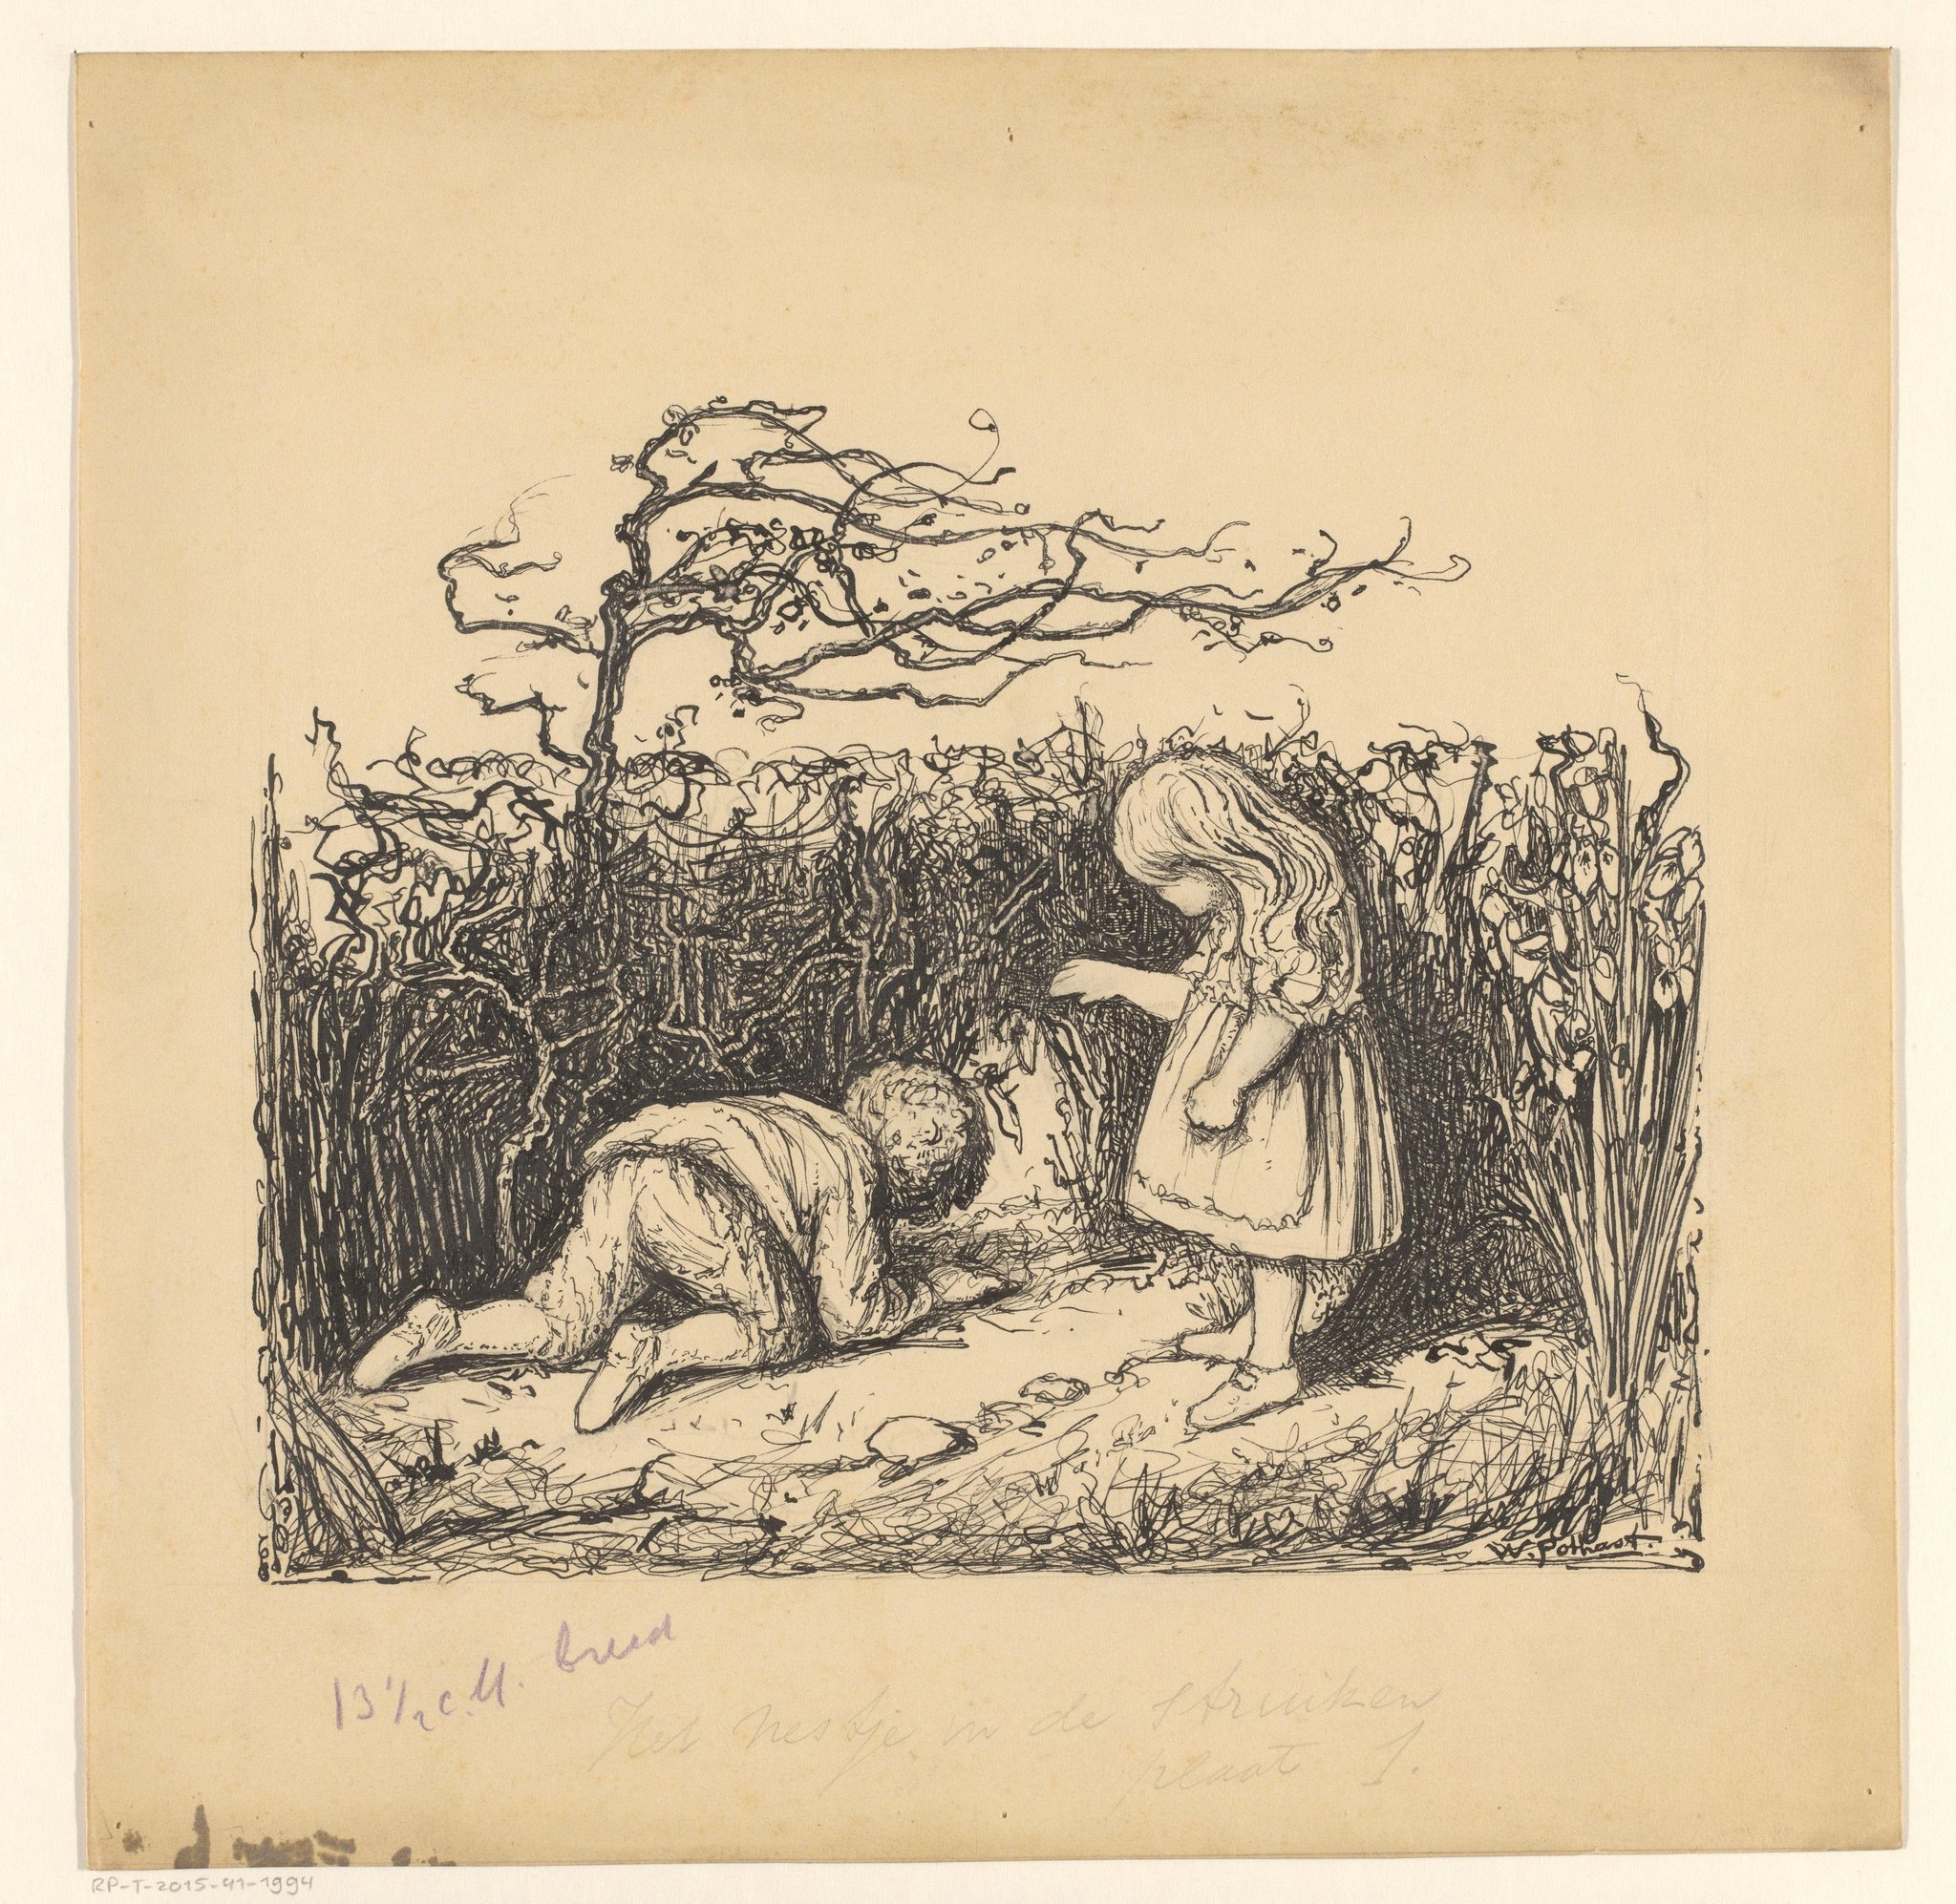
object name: drawing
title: Jongen en meisje bij een struik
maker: willem pothast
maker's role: draughtsman, print maker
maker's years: 1877-1916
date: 1887-1916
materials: ink, paper, pencil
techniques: pen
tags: boy (child between toddler and youth), shrubs, girl (child between toddler and youth)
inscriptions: signature: ‘W. Pothast.’, annotation: ‘Het nestje in de struiken/ plaat 1.’, collector's mark: Lugt 2228, :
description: Een jongen ligt op zijn knieën bij een opening in een struik. Een meisje staat ernaast en houdt met haar hand takken opzij.